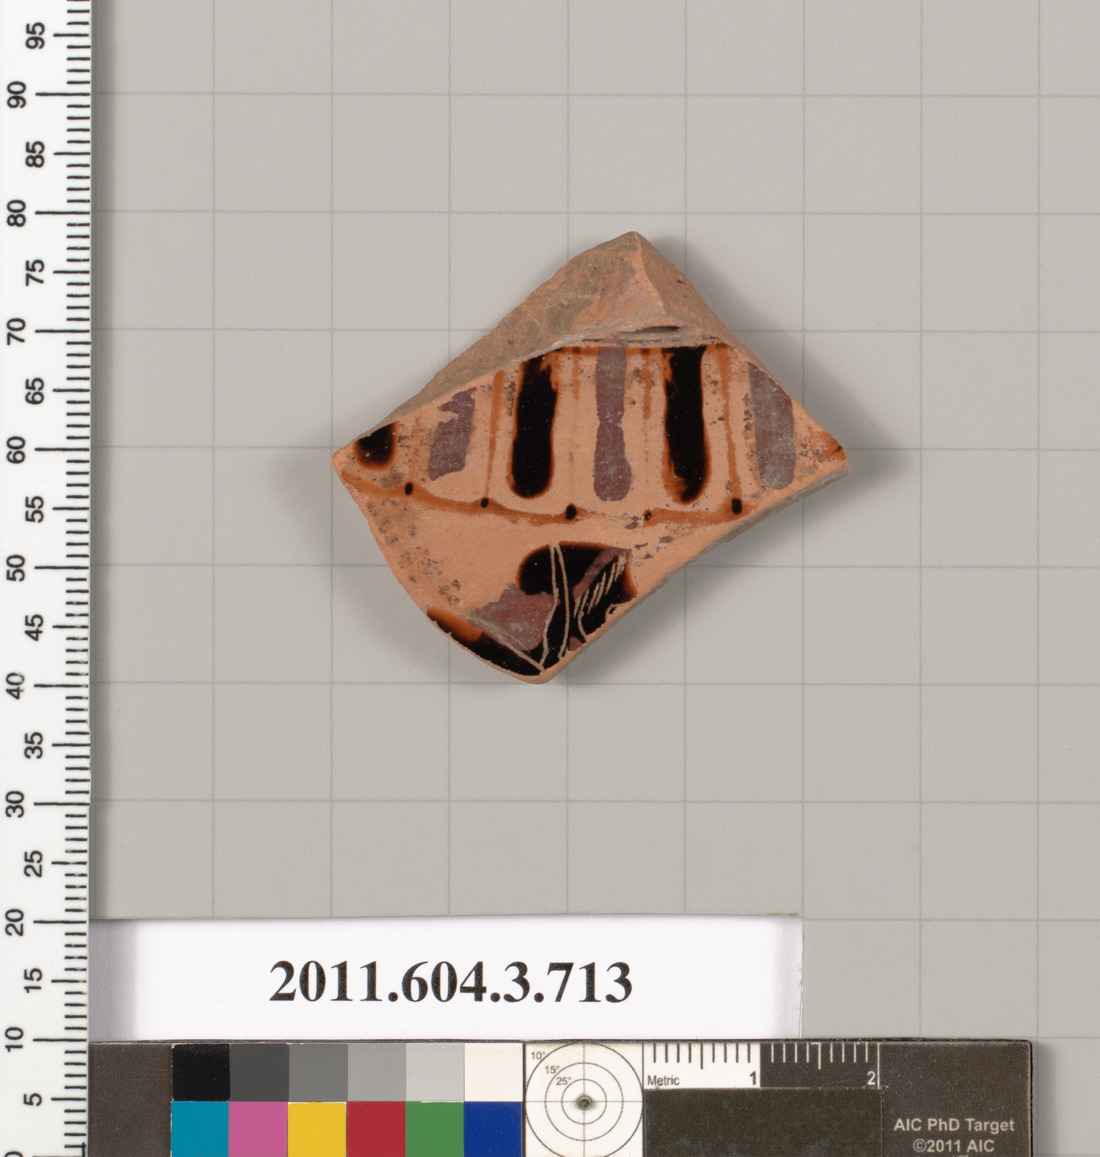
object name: hydria fragment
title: Terracotta fragment of a hydria (water jar)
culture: greek, attic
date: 525-501 BCE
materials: terracotta